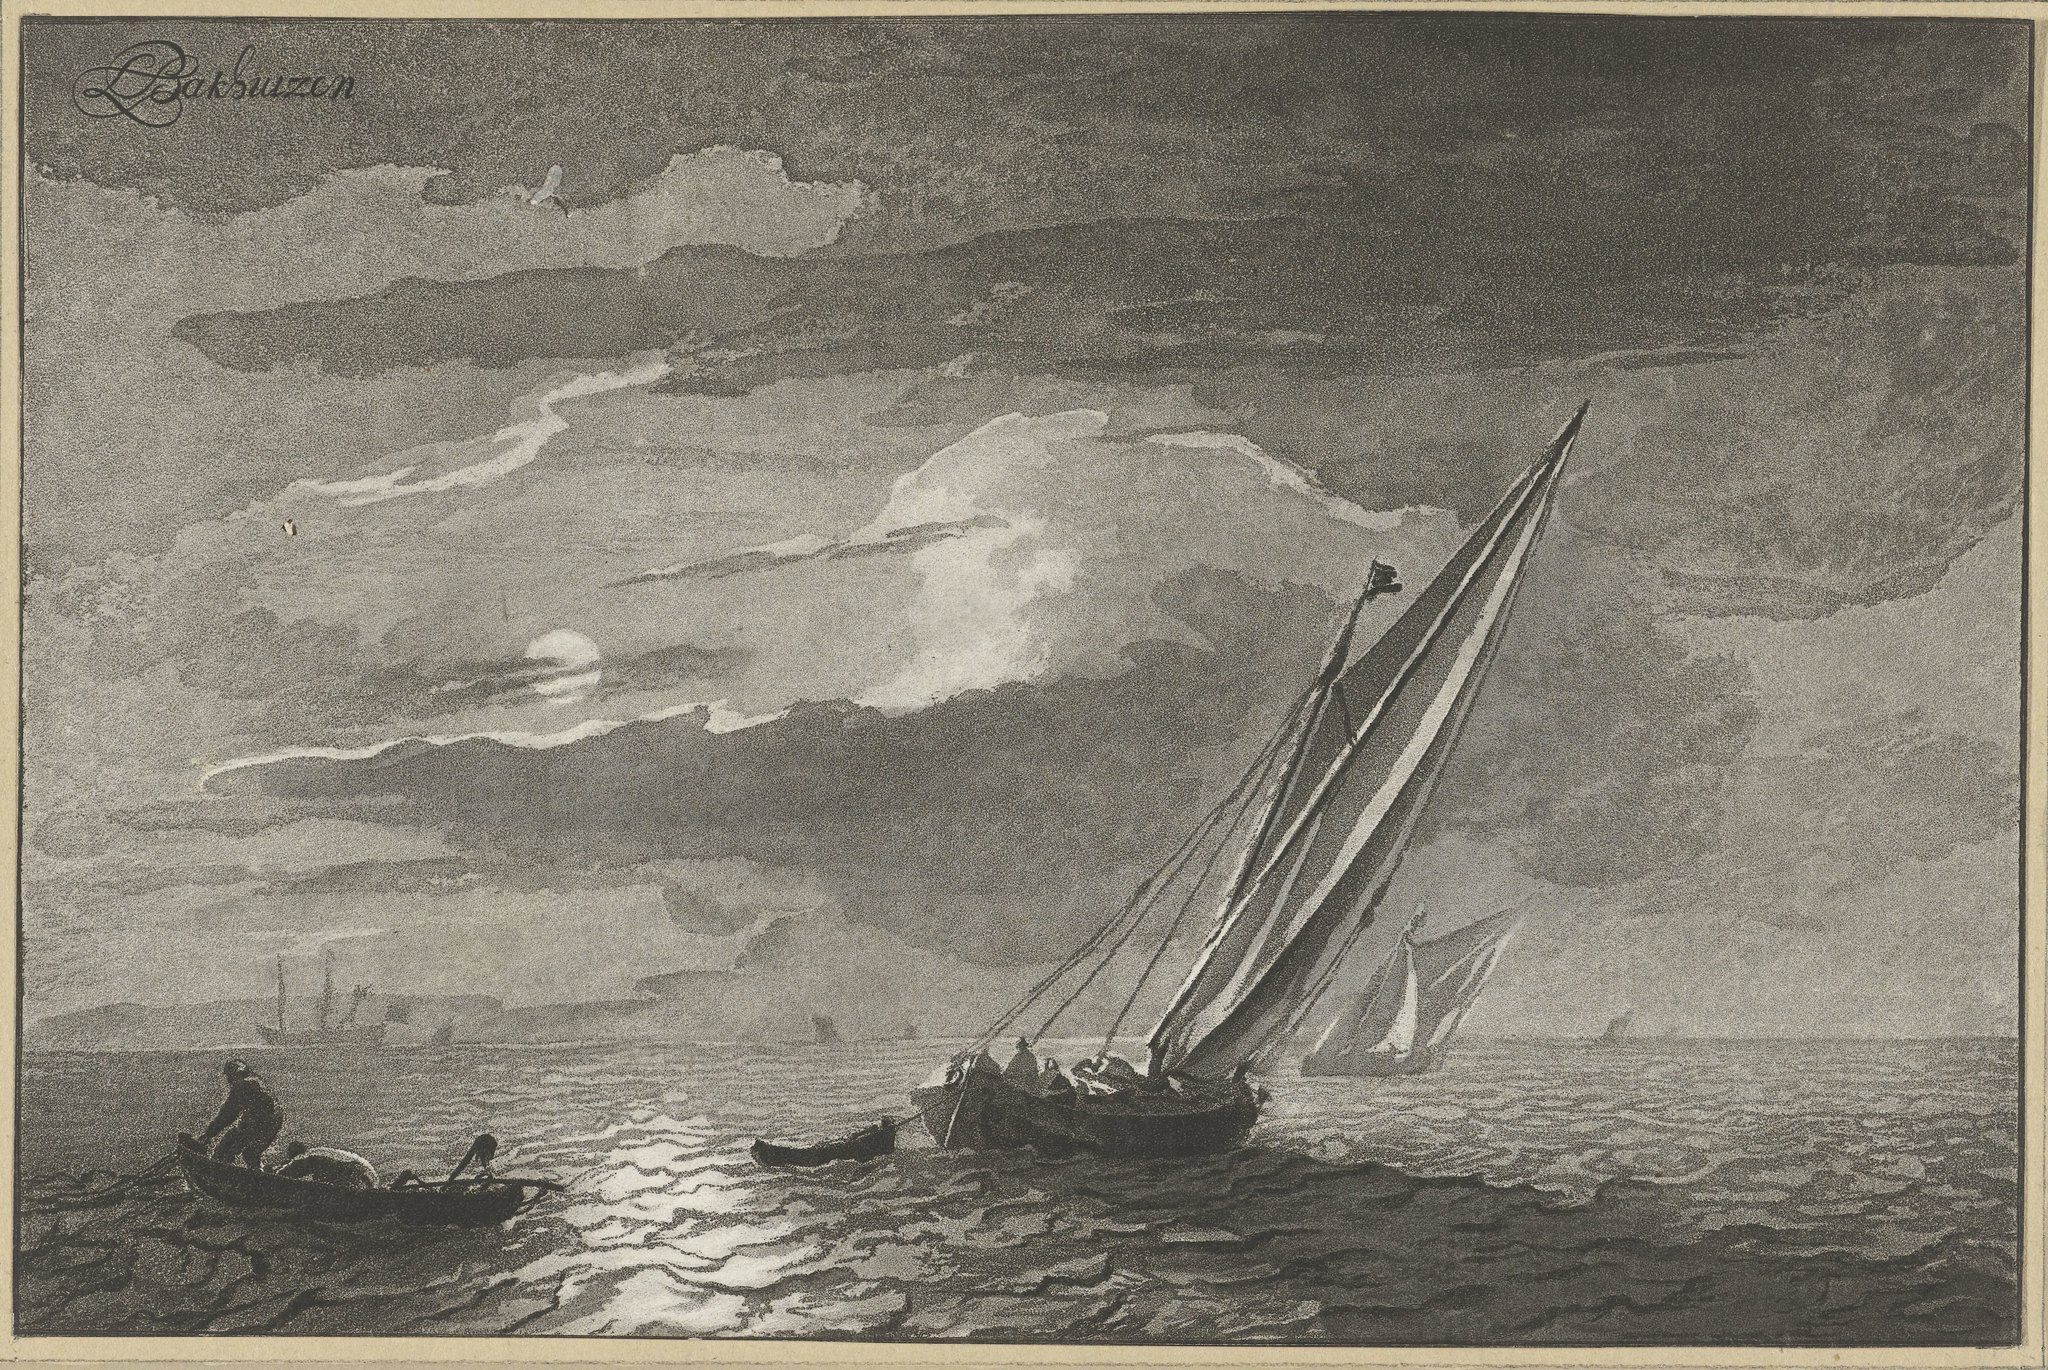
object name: print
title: Zeegezicht met volle maan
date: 1779-1781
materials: paper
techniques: transfer, print drawing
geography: amsterdam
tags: sailing-ship, sailing-boat, moonlight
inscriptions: collector's mark: Lugt 2725, collector's mark: Lugt 12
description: Op zee varen twee zeilschepen. Een visser haalt vanuit een sloep zijn netten binnen.